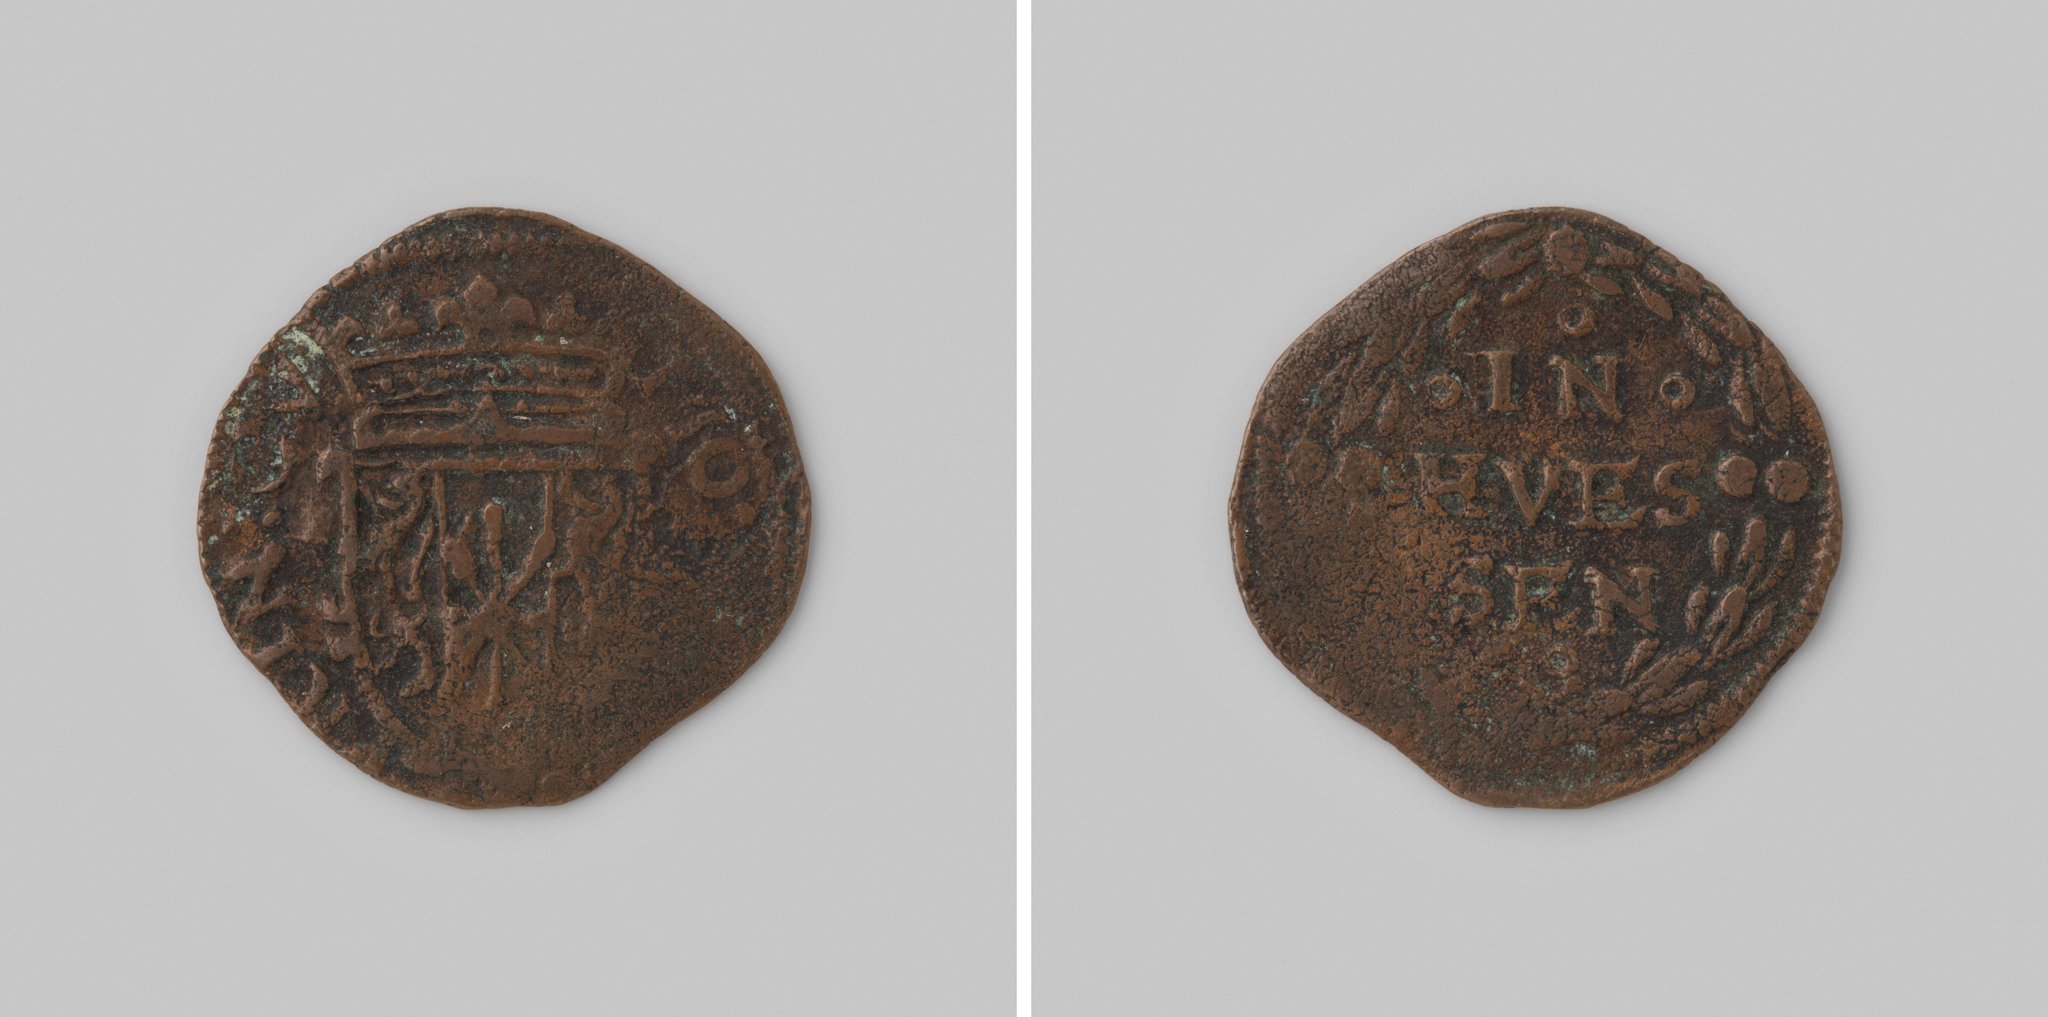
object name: coin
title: Huissen, duit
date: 1609-1626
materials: copper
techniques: striking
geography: huissen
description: Koperen munt. Voorzijde: gekroond wapenschild van de possiderende vorsten. Keerzijde: binnen twee halve lauwerkransen opschrift in drie regels.